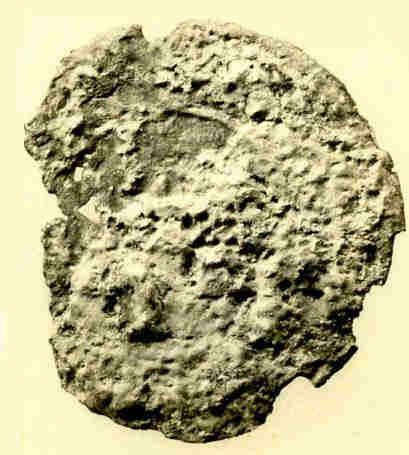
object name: coin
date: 401-1400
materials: silver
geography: iran